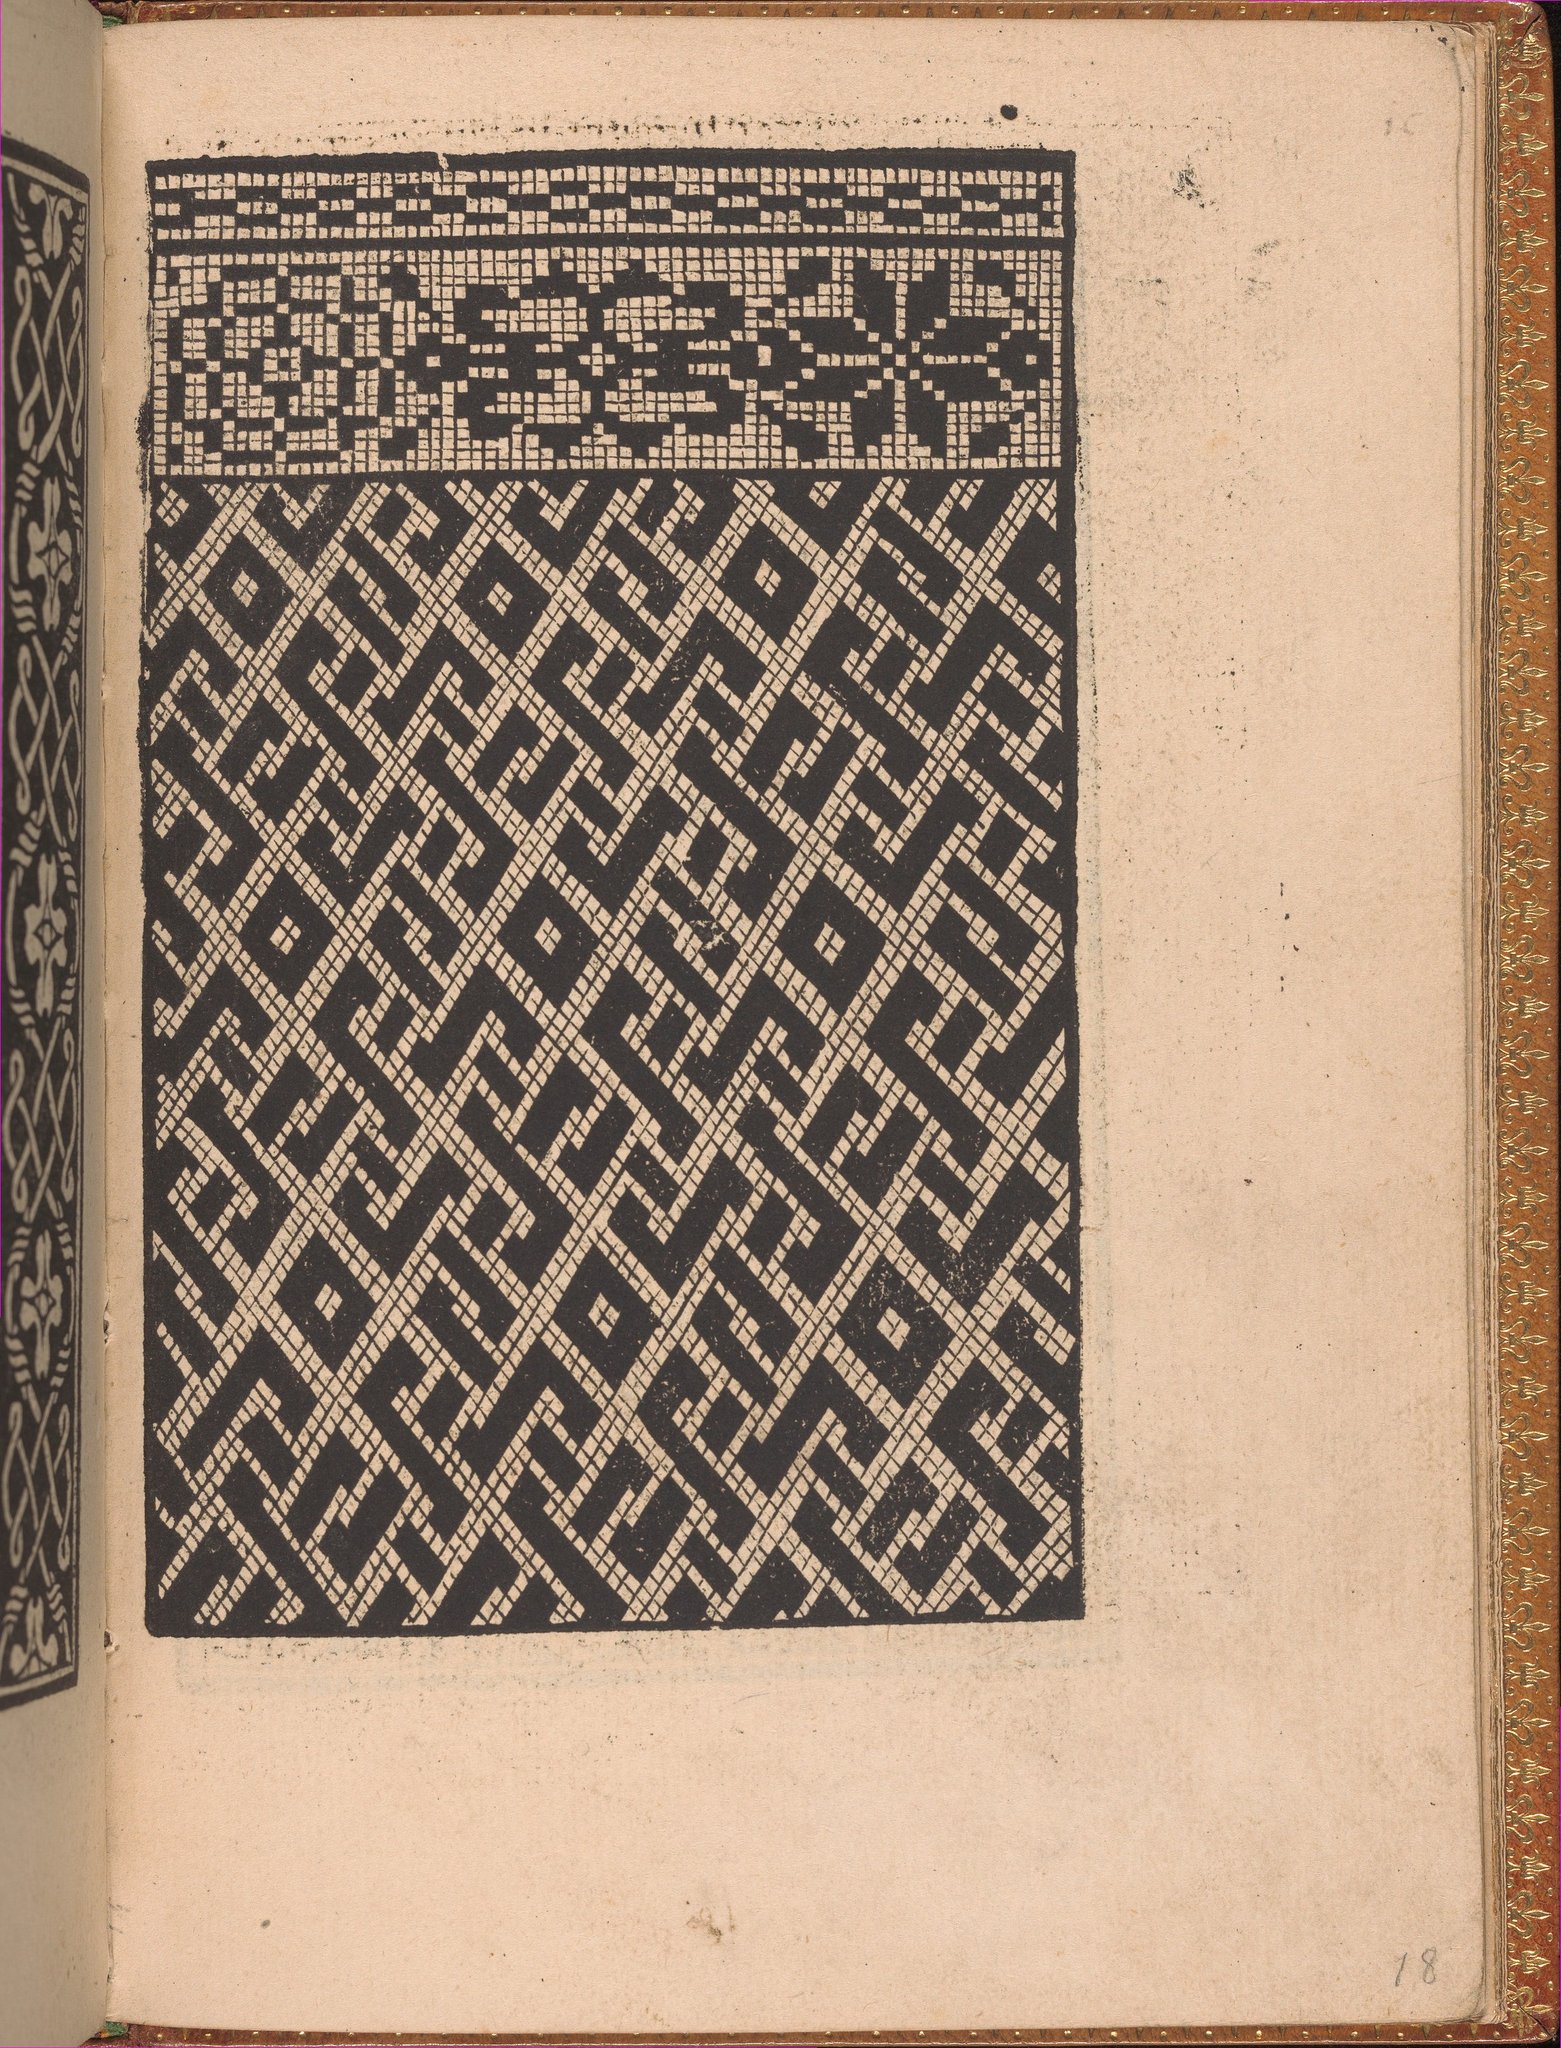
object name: book print ornament architecture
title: Convivio delle Belle Donne, page 18 (recto)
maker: nicolò zoppino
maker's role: publisher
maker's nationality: italian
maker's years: 1478-1544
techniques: woodcut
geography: italy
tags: ornament